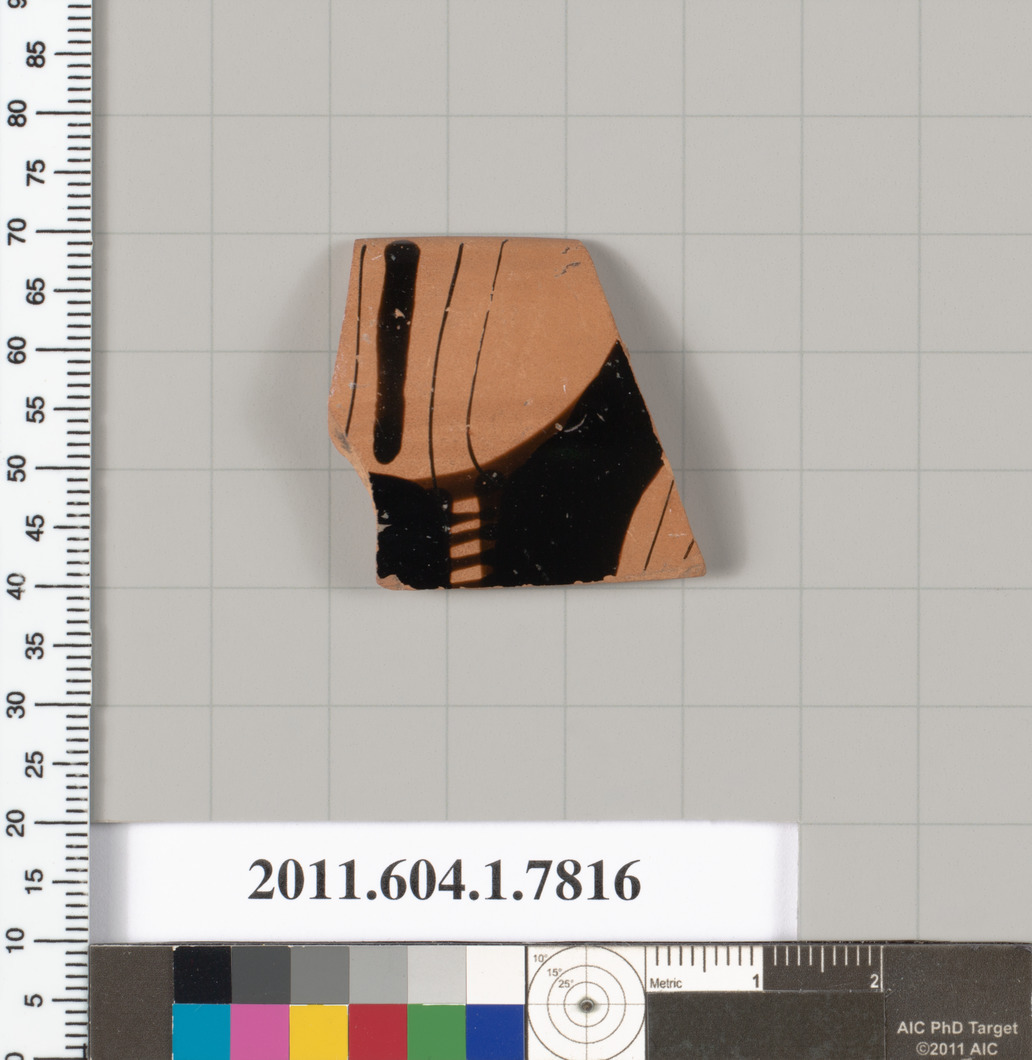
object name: kylix fragment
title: Terracotta rim fragment of a kylix (drinking cup)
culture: greek, attic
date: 460-450 BCE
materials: terracotta